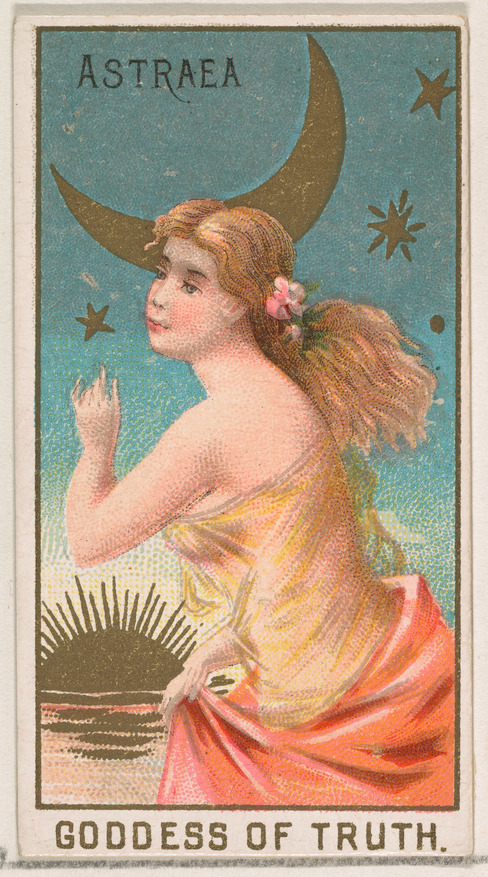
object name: print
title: Astraea, Goddess of the Truth, from the Goddesses of the Greeks and Romans series (N188) issued by Wm. S. Kimball & Co.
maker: william s. kimball & company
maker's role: publisher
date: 1889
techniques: color lithograph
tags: goddess